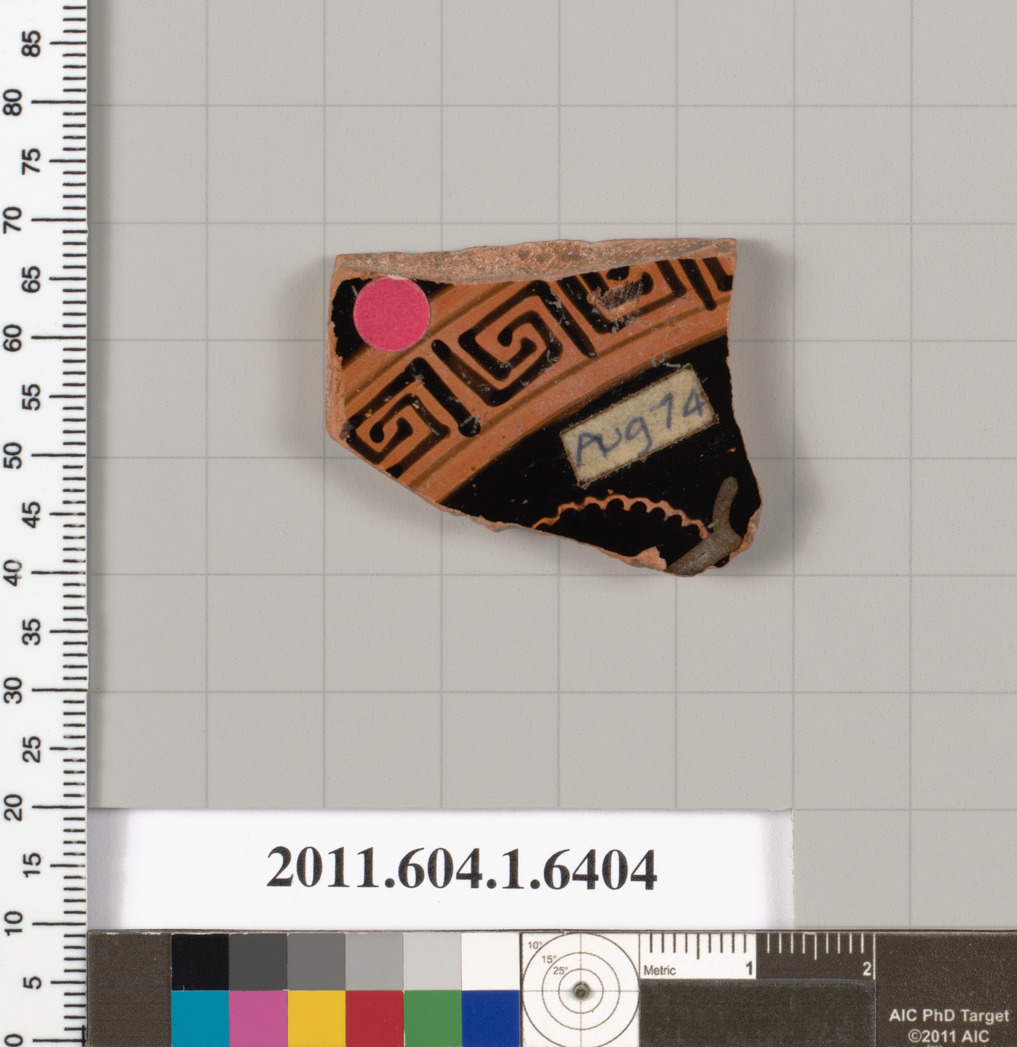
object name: kylix fragment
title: Terracotta fragment of a kylix (drinking cup)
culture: greek, attic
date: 490-480 BCE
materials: terracotta